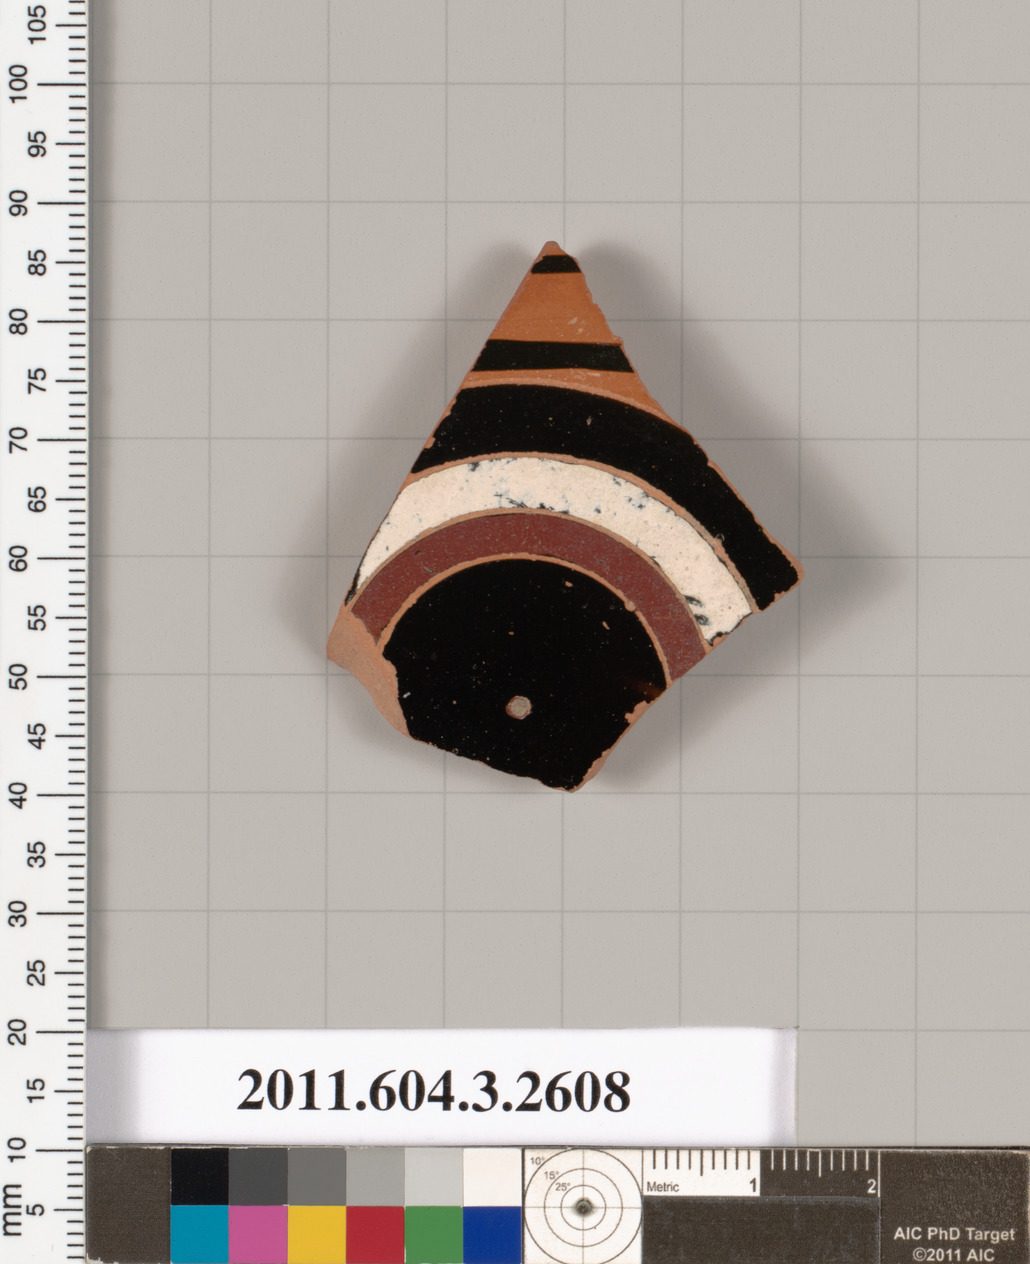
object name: kylix fragment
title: Terracotta fragment of a kylix (drinking cup)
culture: greek, attic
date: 530-510 BCE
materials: terracotta